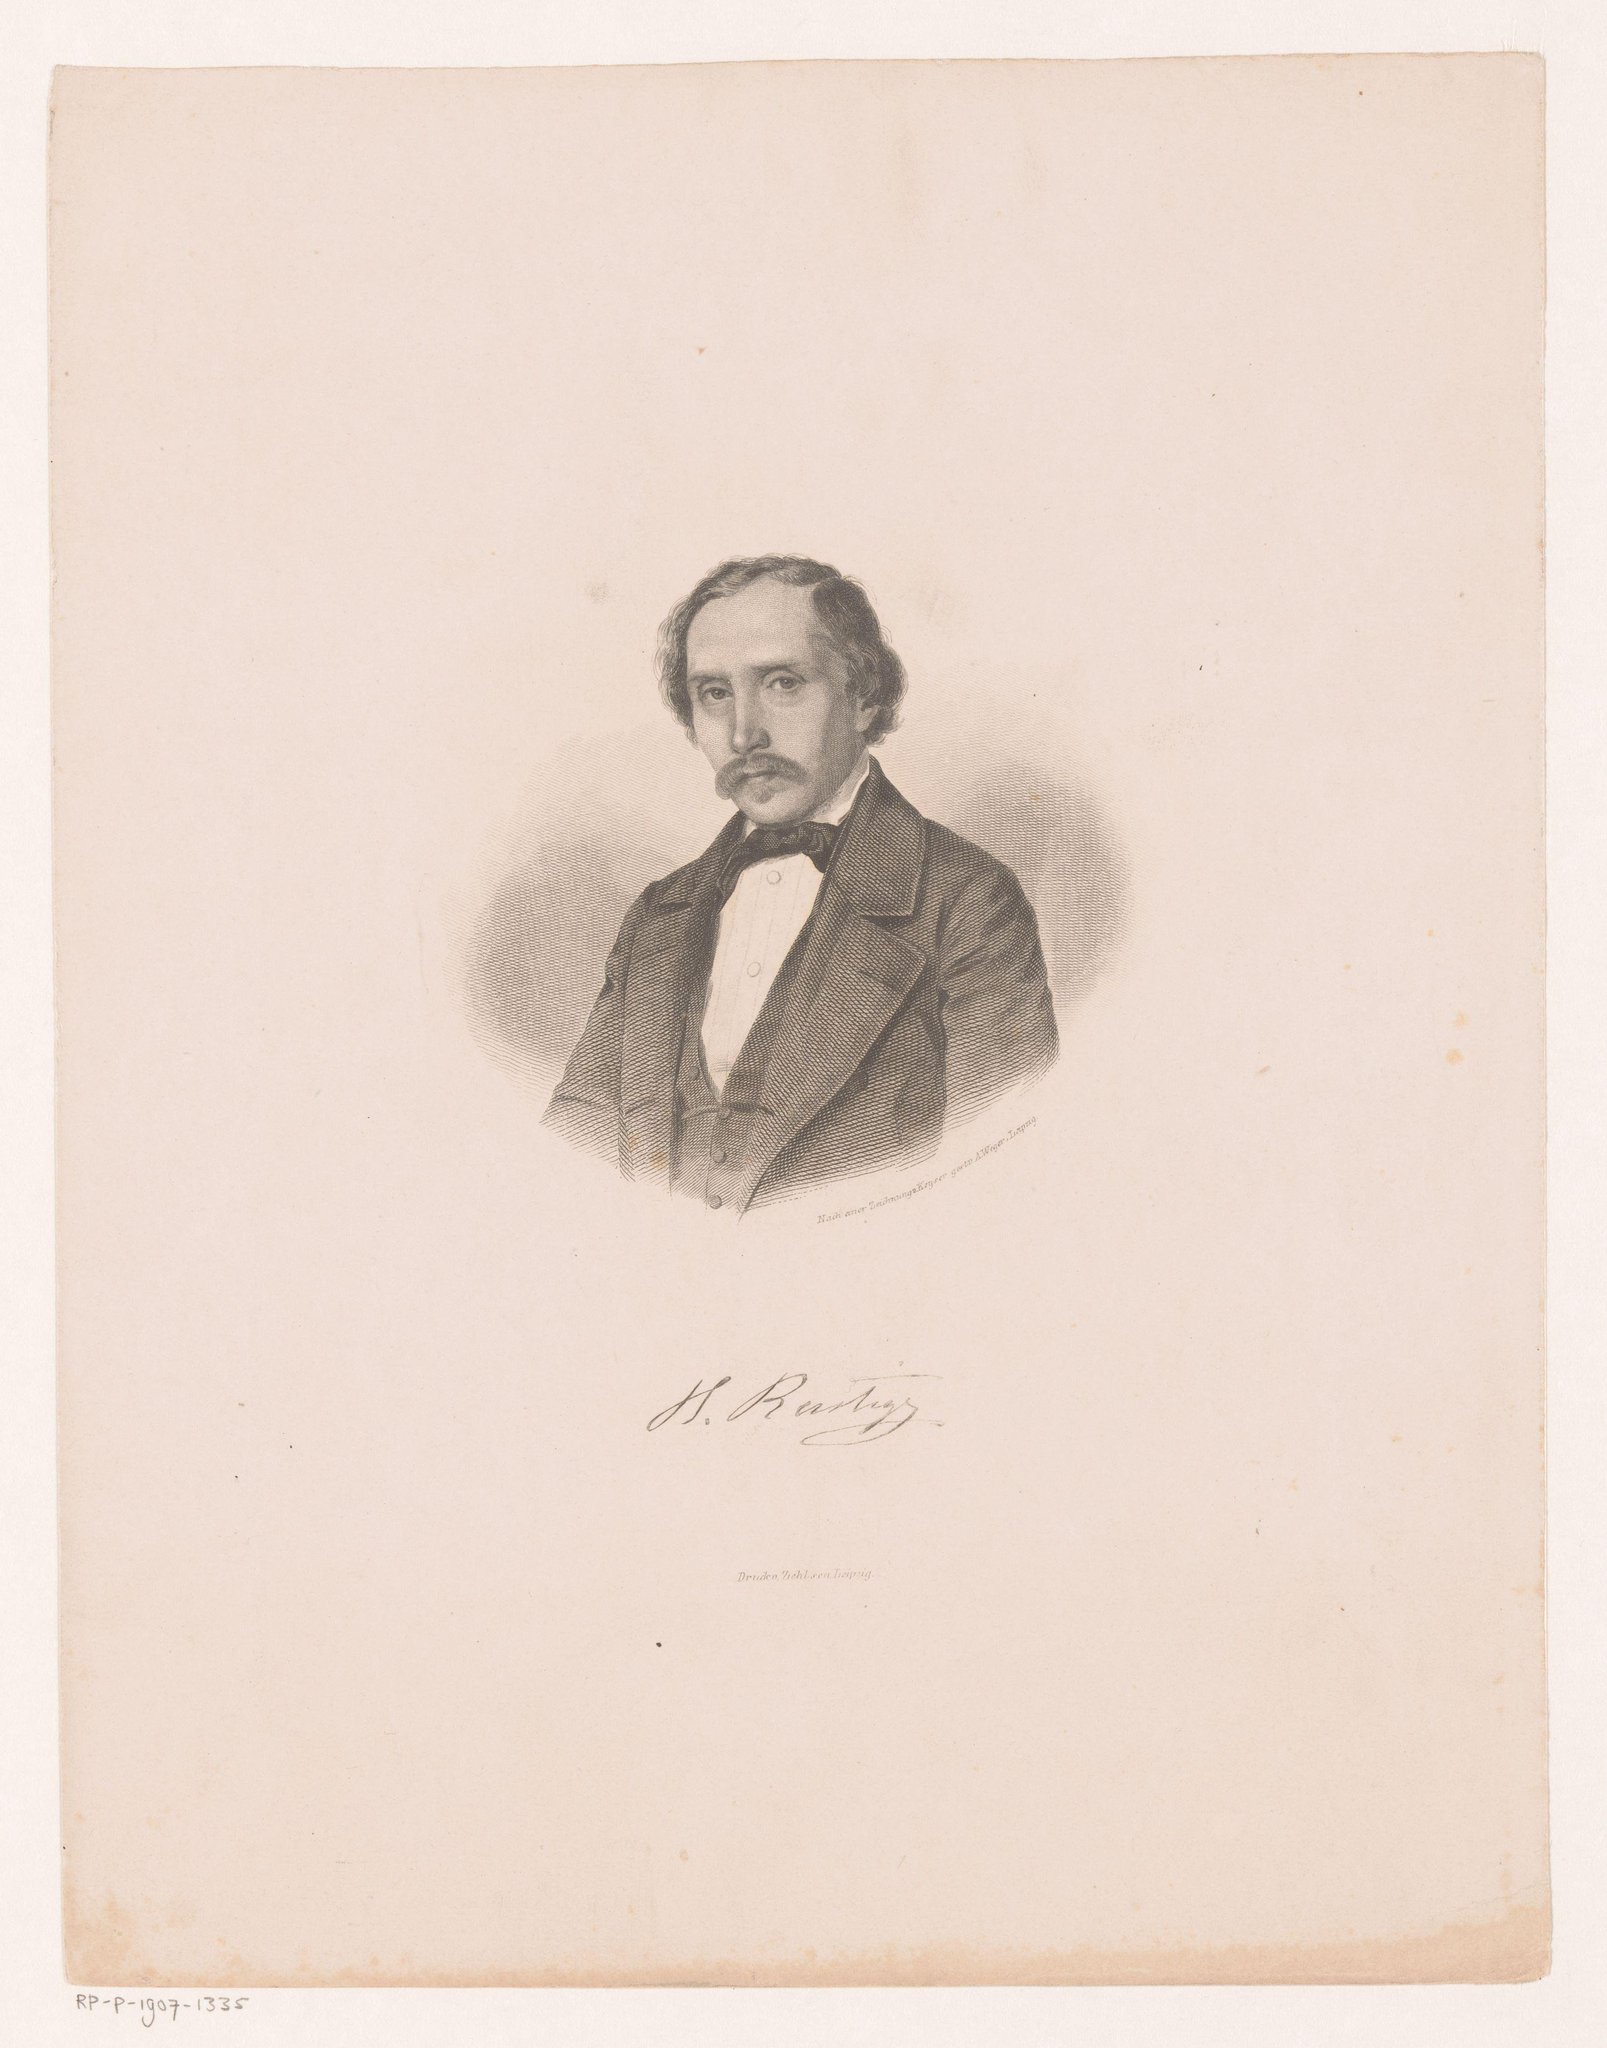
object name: print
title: Portret van Heinrich Franz Gaudenz von Rustige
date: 1849-1892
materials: paper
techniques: engraving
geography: leipzig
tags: painter, print maker, historical persons, portrait, self-portrait of artist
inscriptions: collector's mark: Lugt 2228